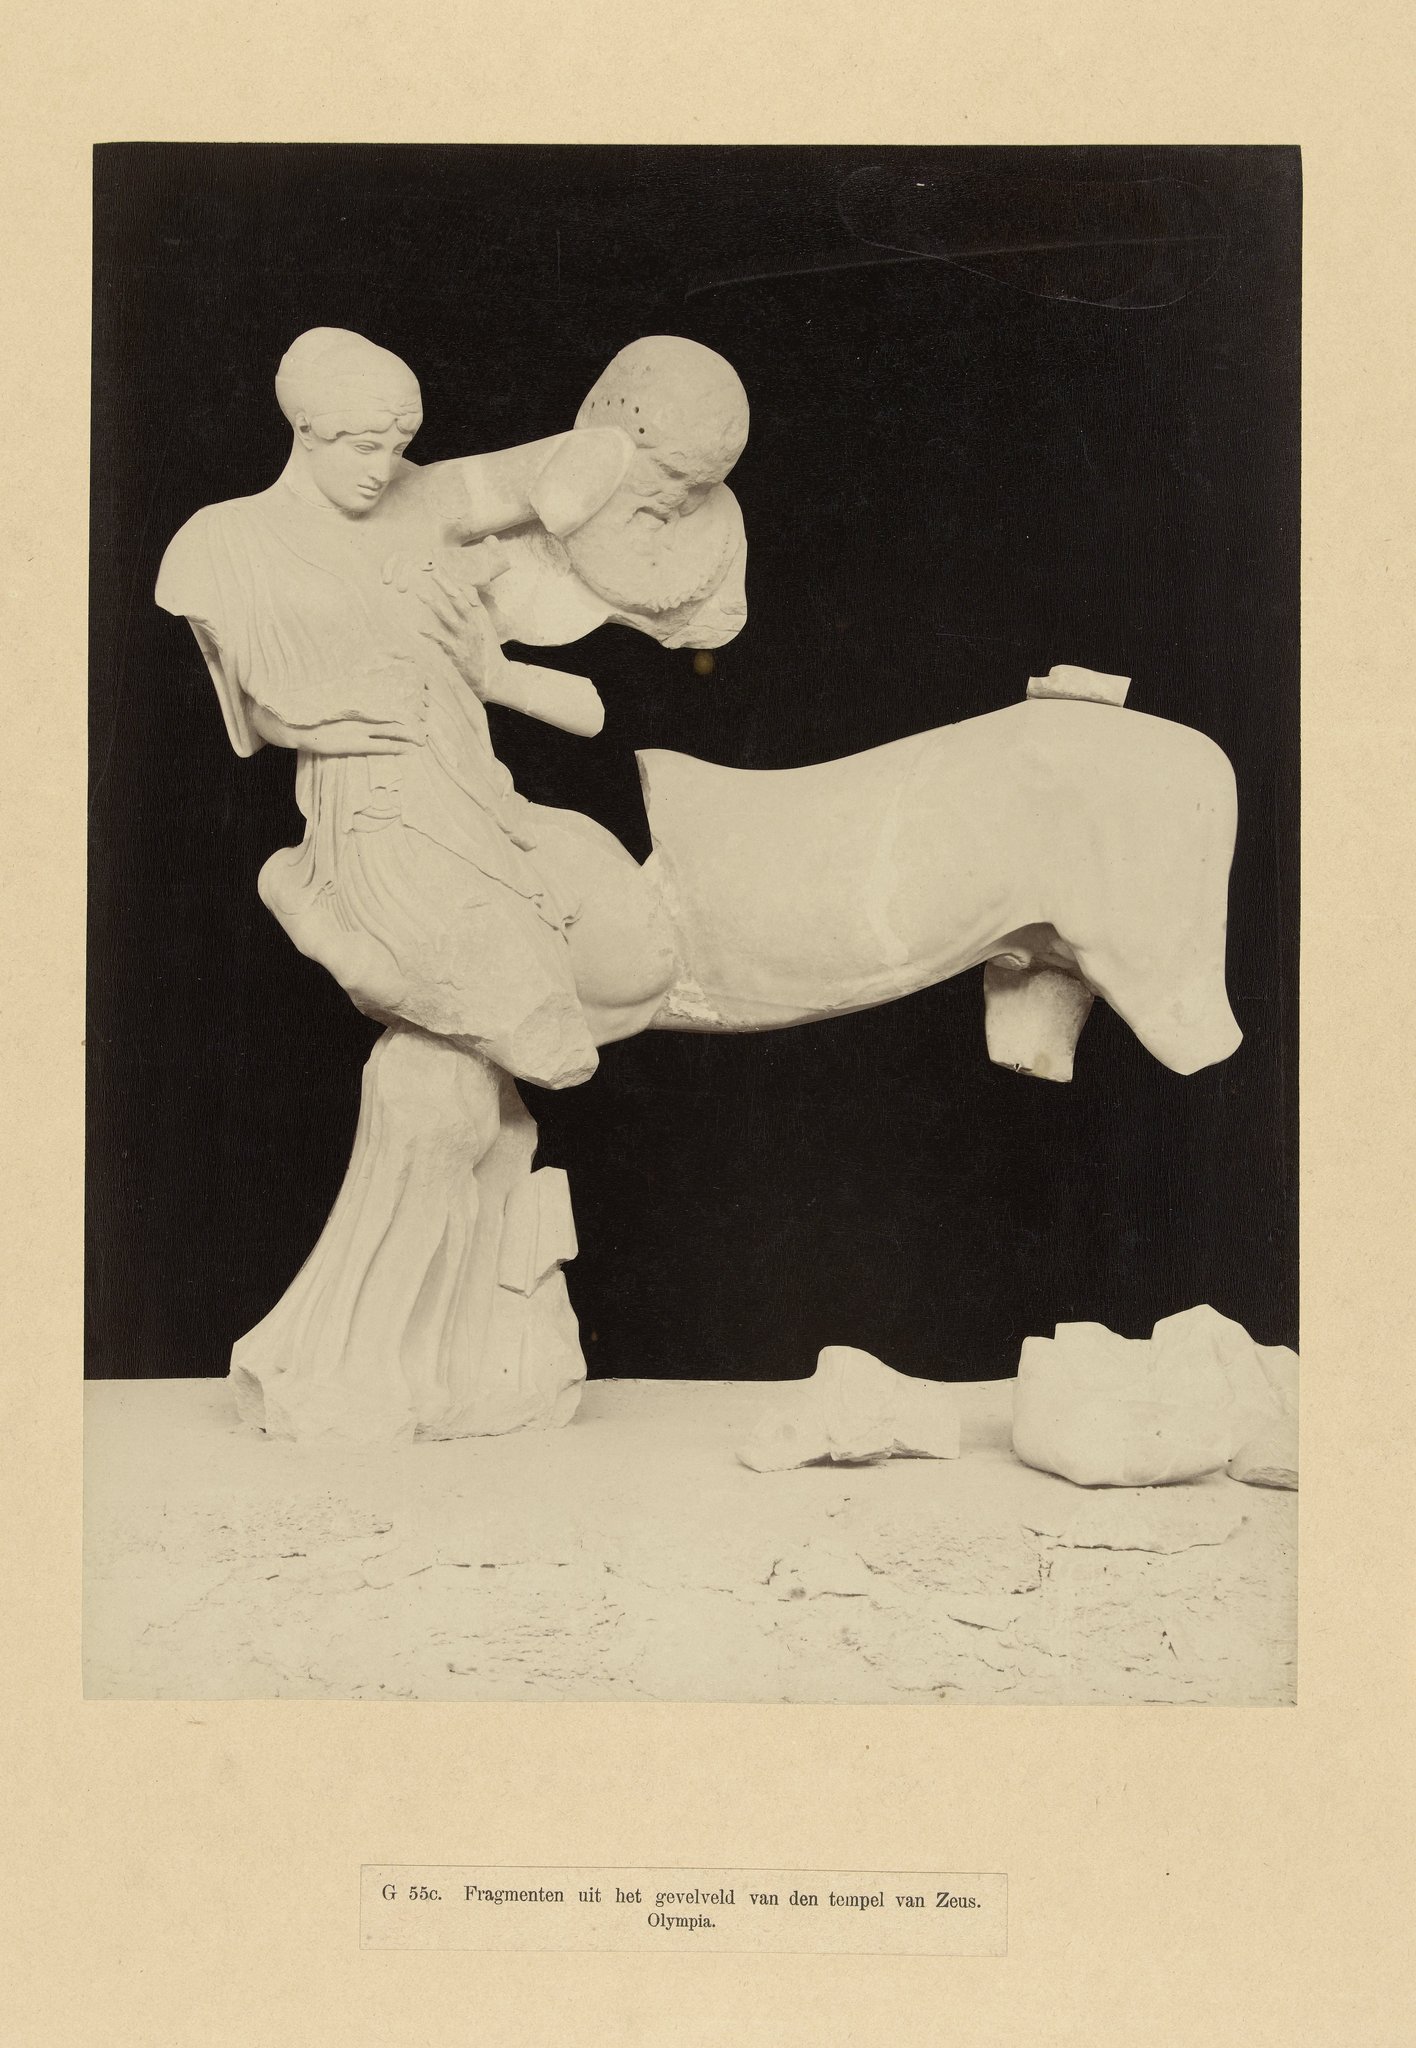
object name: photograph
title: Beeld van een centaur die een vrouw belaagt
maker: Anonymous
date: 1890-1895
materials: cardboard, paper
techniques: albumen print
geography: olympia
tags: piece of sculpture, reproduction of a piece of sculpture, aggressive, unfriendly activities and relationships of centaurs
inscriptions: title: ‘G 55C. Fragmenten uit het gevelveld van den tempel van Zeus./ Olympia.’, stamp: ‘Gemeentelijke bibliotheek/ Rotterdam’, watermark: ‘BFK Rives’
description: Onderdeel van een groep door fotograaf Richard Polak op reis verzamelde foto’s. Deze foto is samen met andere op zijn reizen verzamelde foto's tentoongesteld bij de Rotterdamsche Kunstkring (1895), Arti en Amicitiae te Amsterdam (1897-1898?) en Societeit 't Collegie te Kampen (datum vooralsnog onbekend).